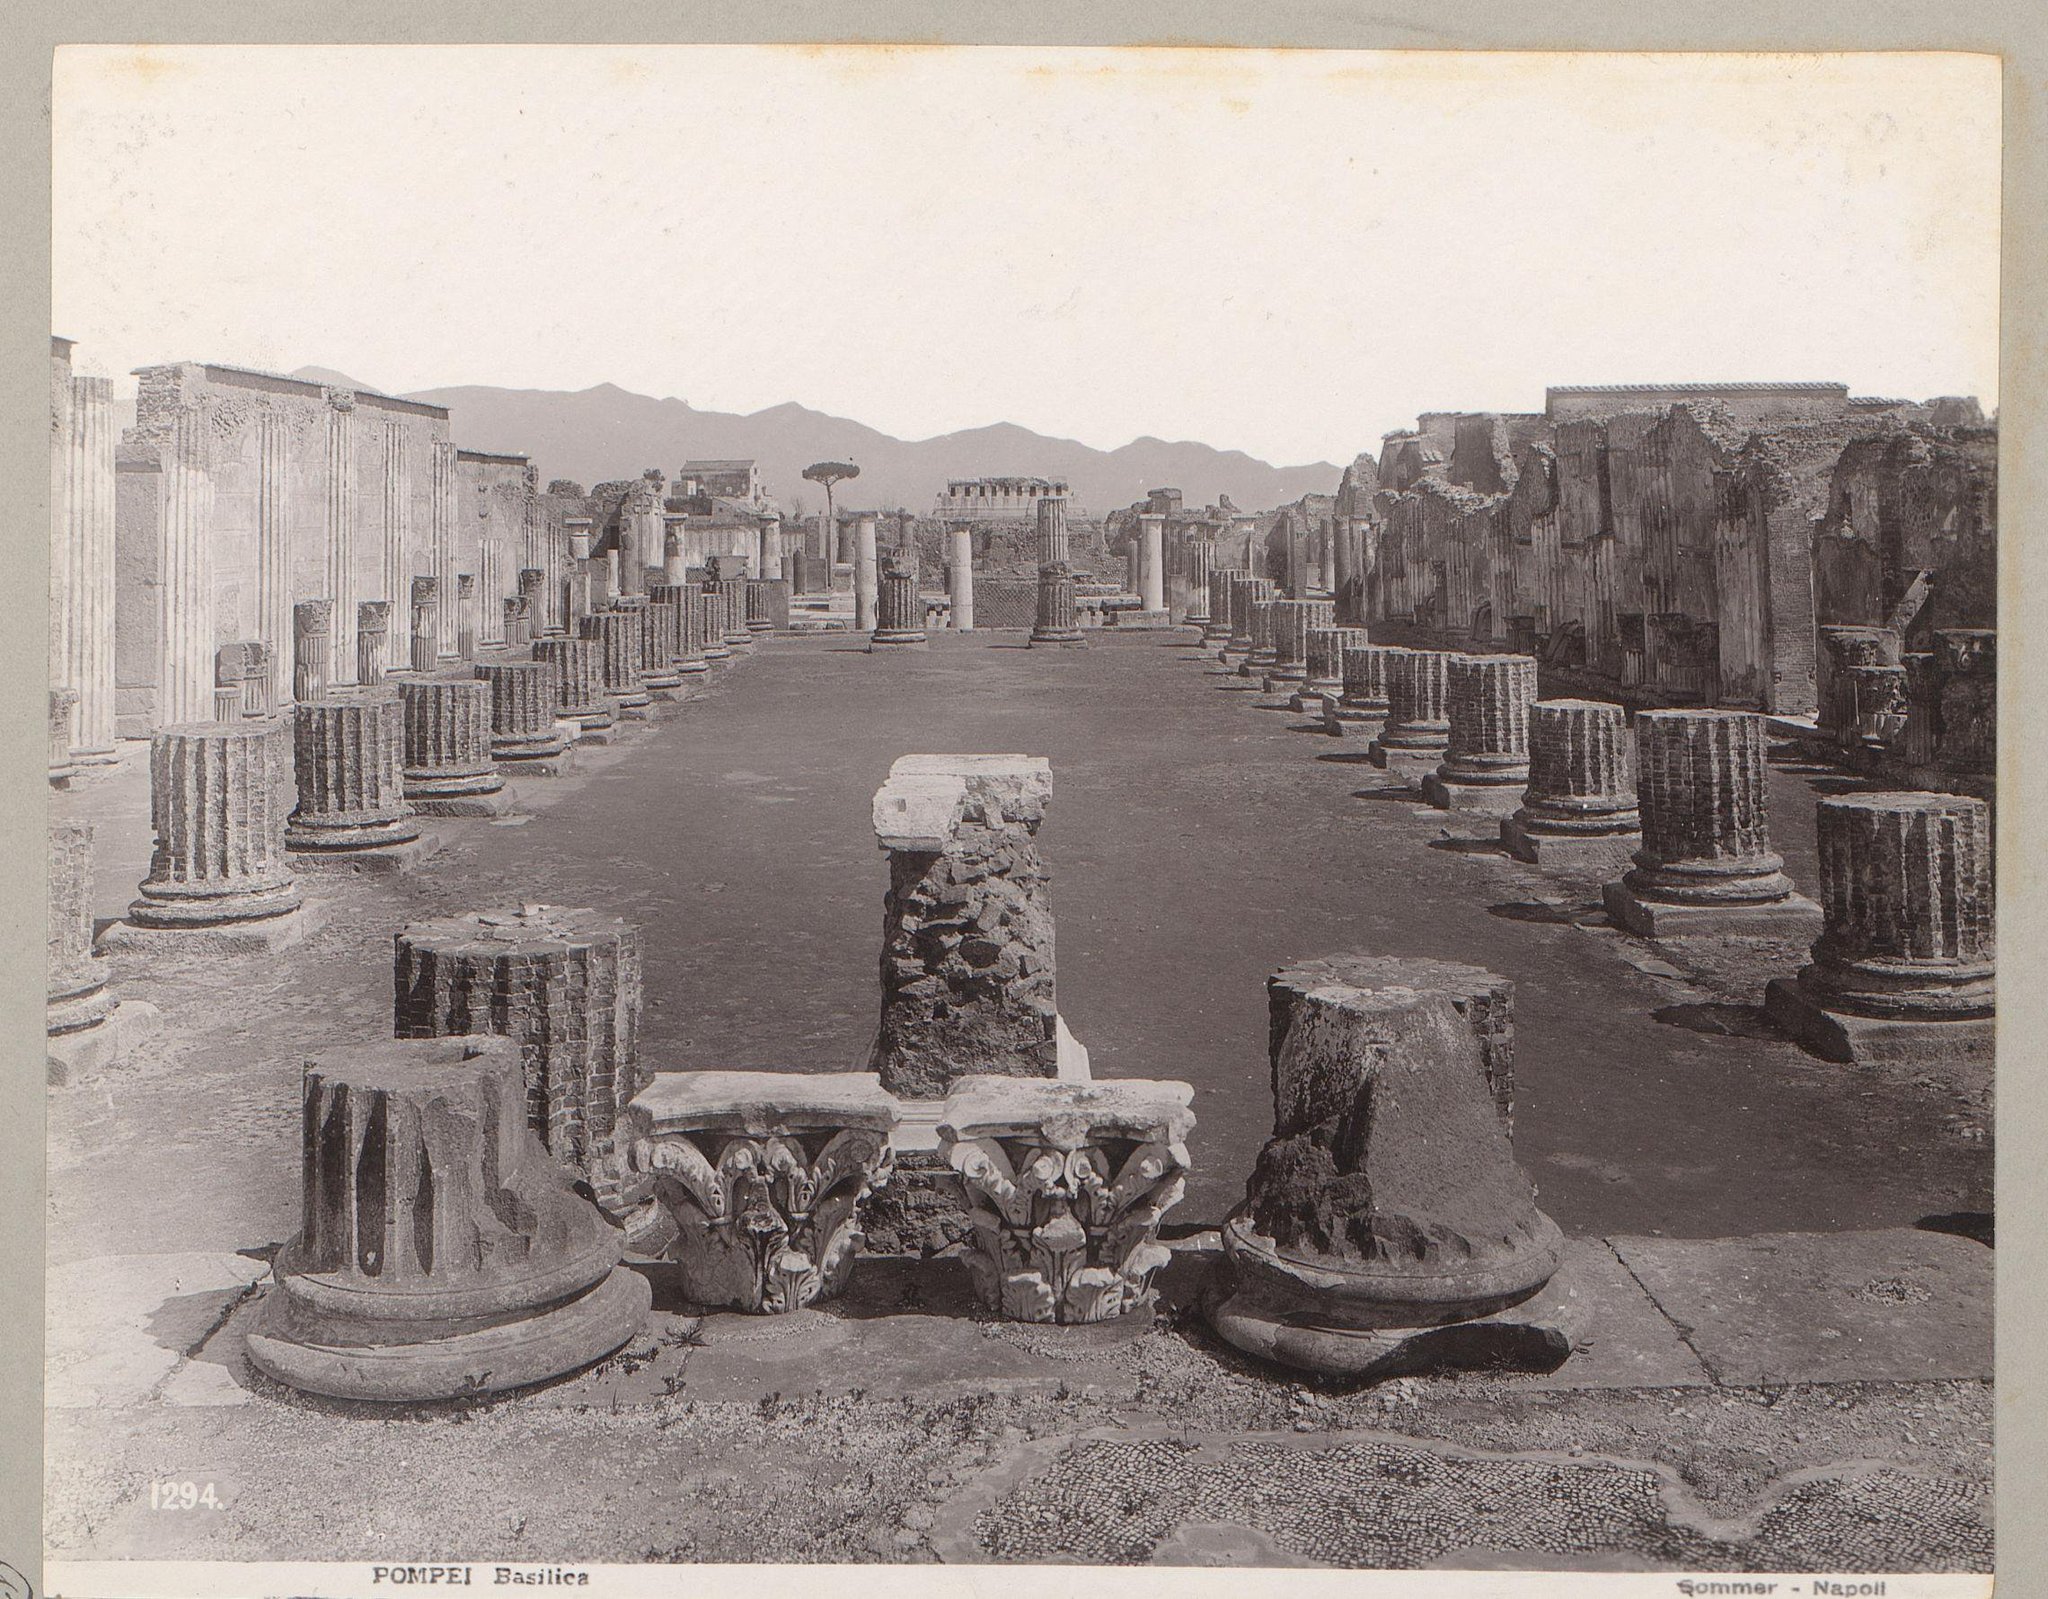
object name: photograph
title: De restanten van de basiliek van Pompeï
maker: giorgio sommer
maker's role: fotograaf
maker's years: 1834-1914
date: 1888-1903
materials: cardboard, photographic support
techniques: albumen print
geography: netherlands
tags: pompeii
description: De restanten van de basiliek van Pompeï die duidelijk de plattegrond laten zien.